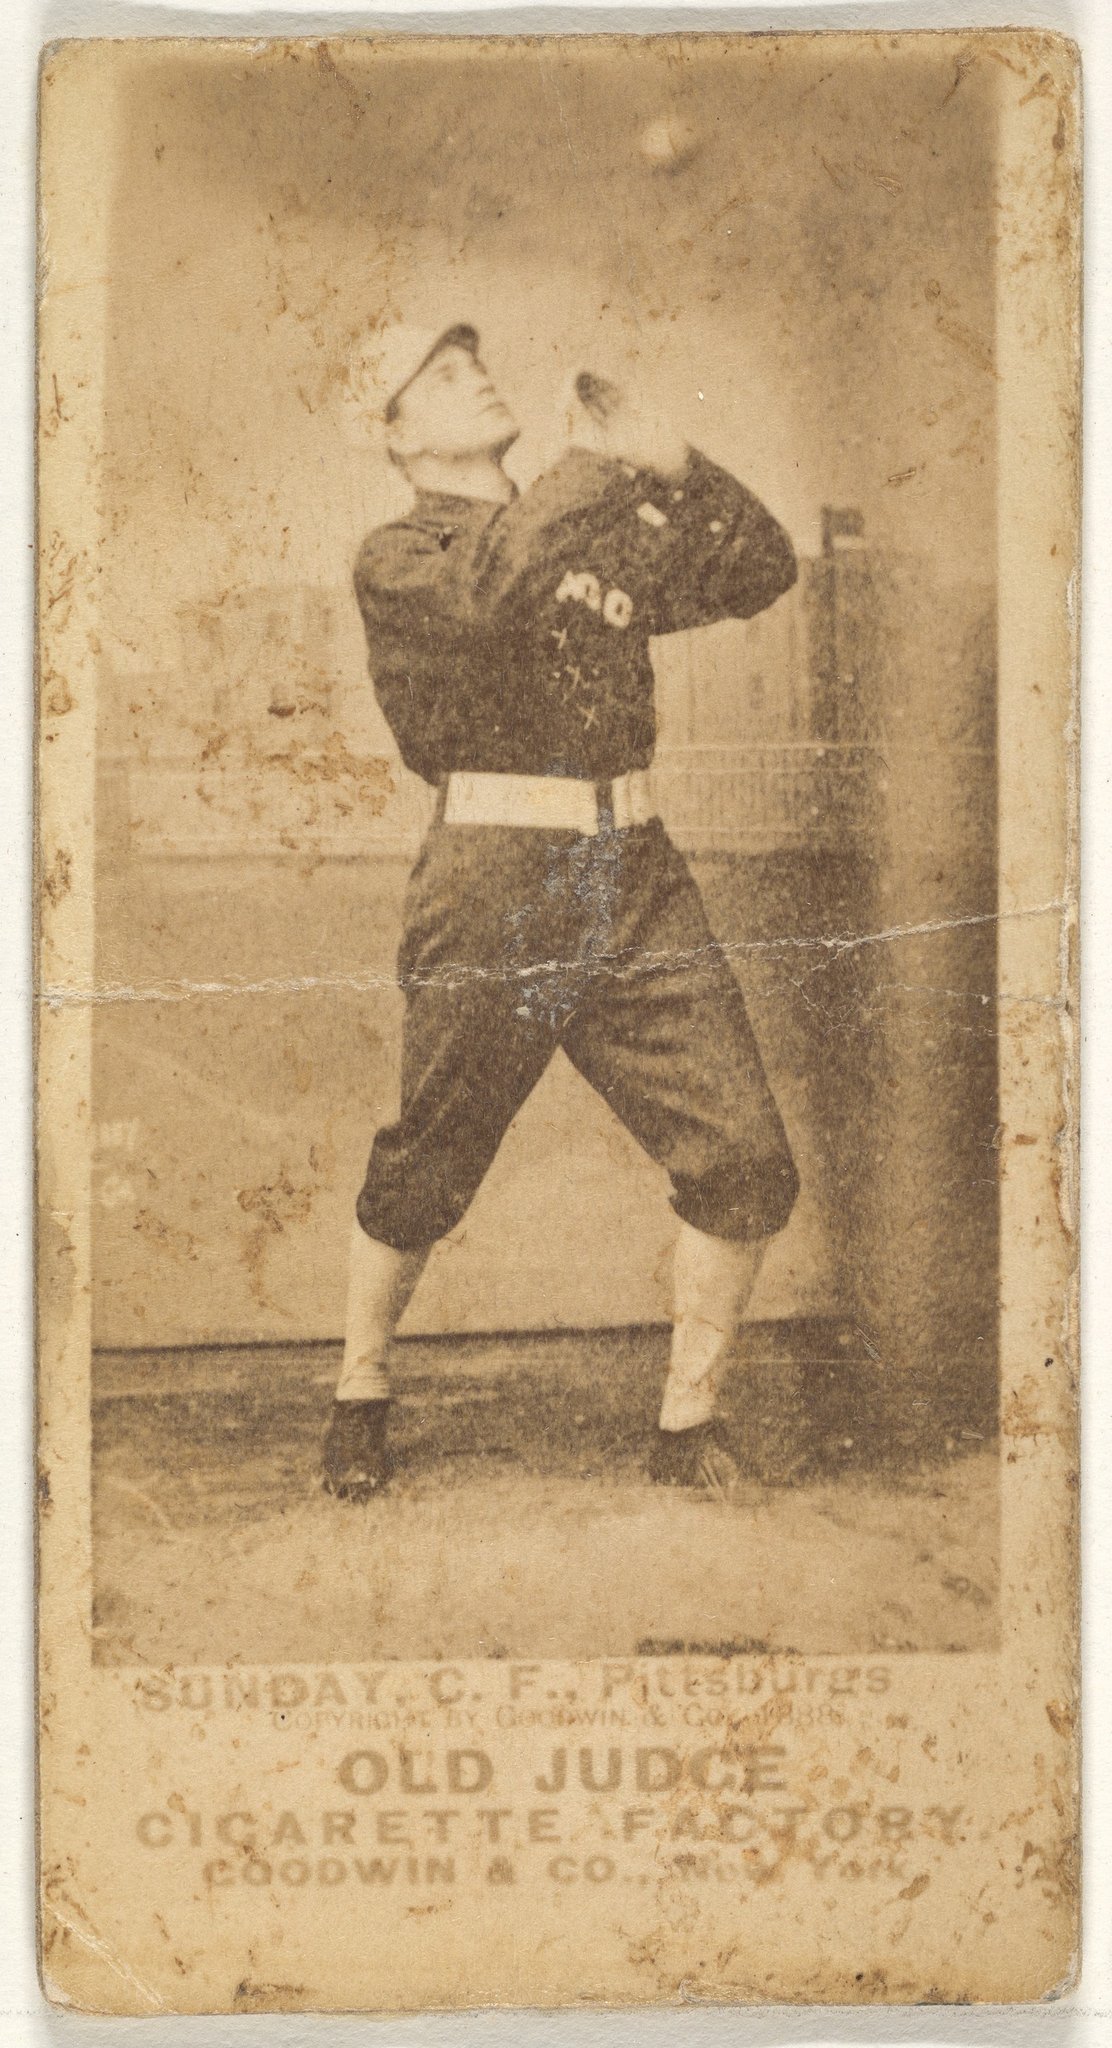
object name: baseball card, photograph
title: William Ashley "Billy" Sunday, Center Field, Pittsburgh, from the Old Judge series (N172) for Old Judge Cigarettes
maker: goodwin & company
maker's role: publisher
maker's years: 1850-1950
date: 1888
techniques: albumen silver print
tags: men,portraits,baseball,athletes